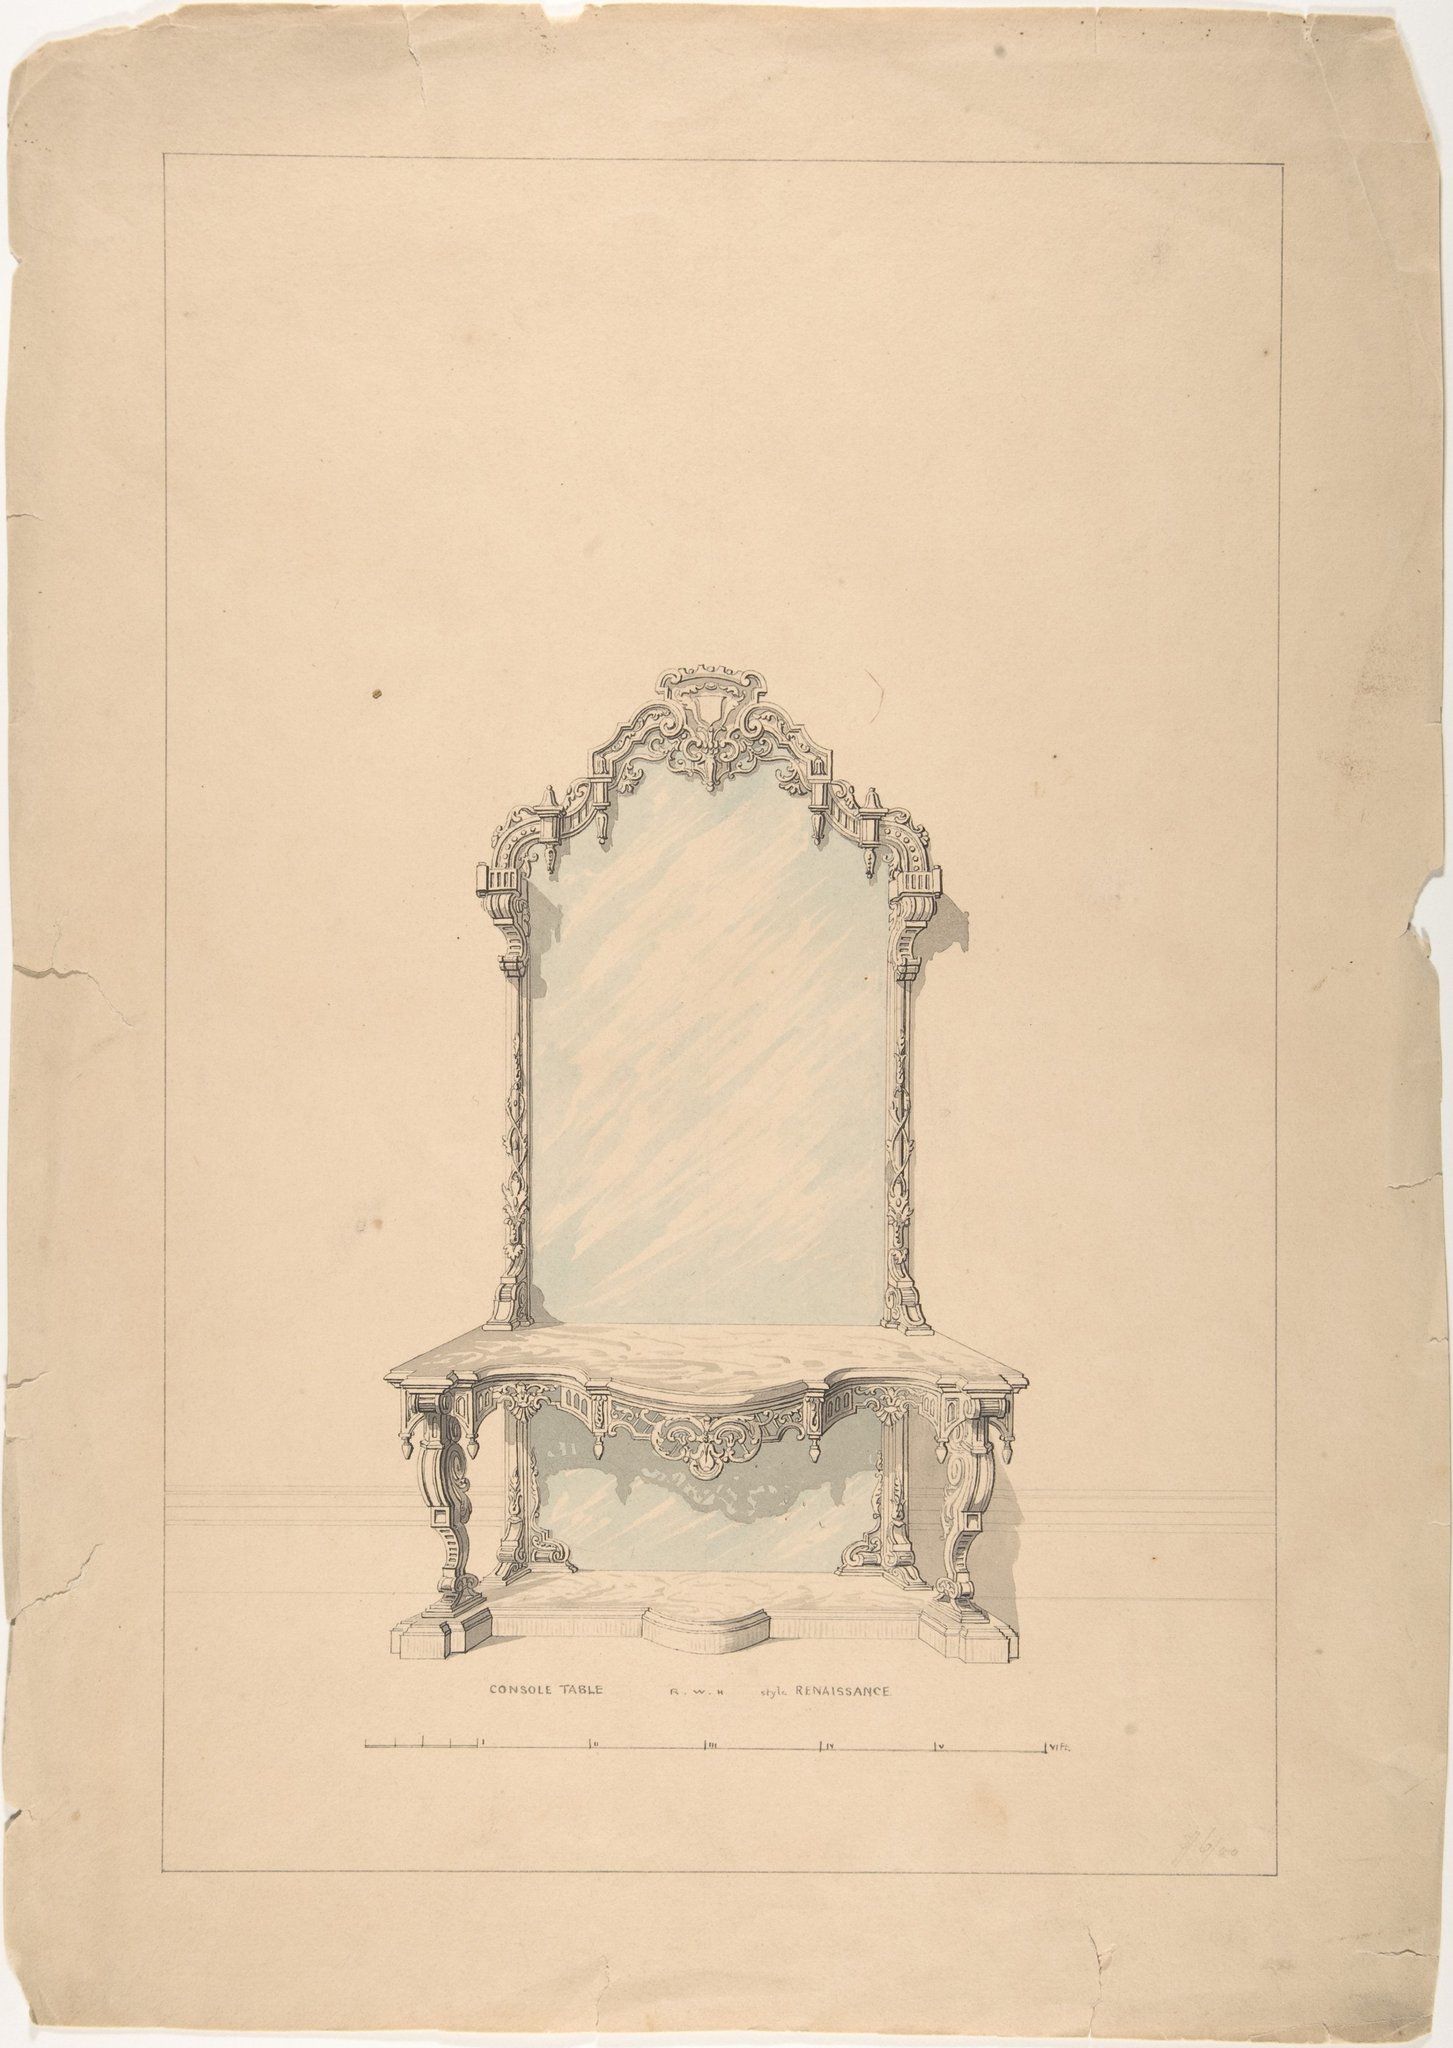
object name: drawing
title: Design for Console Table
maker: robert william hume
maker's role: artist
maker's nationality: british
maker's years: 1816-1904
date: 1850-1904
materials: graphite, ink, watercolor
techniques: pen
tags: tables